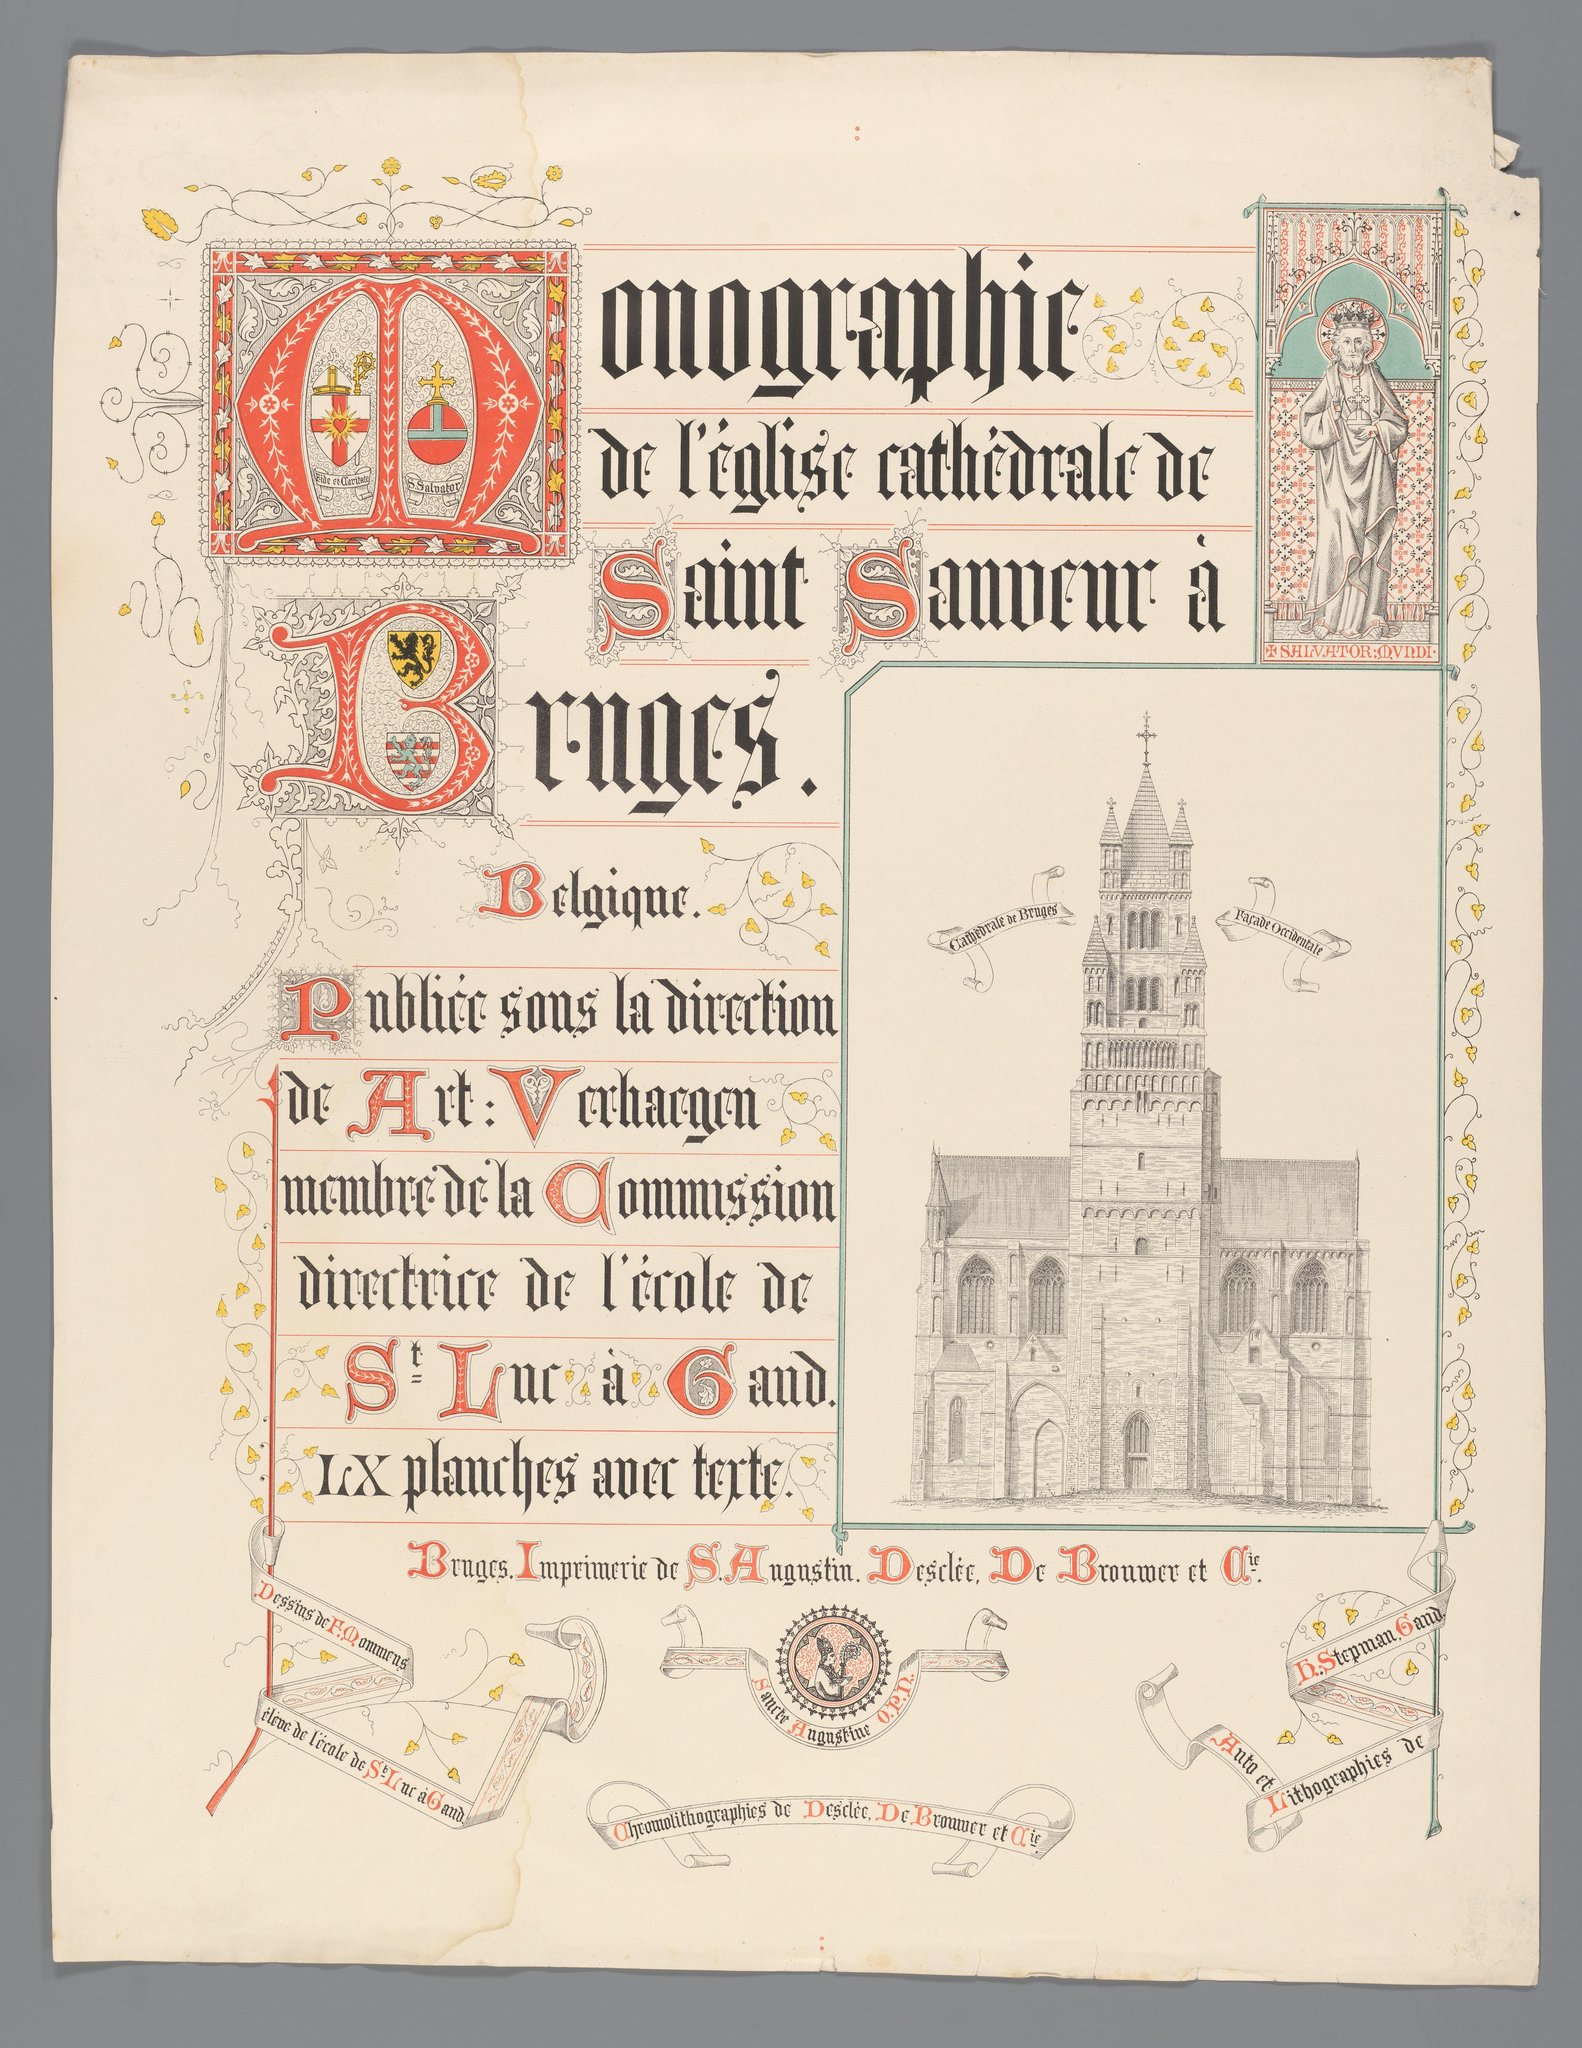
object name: print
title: Sint-Salvatorskathedraal te Brugge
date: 1850-1900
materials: paper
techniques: lithograph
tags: church (exterior), bruges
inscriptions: mark: ‘Dessins de F. Qommius’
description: Blad met gezicht op de Sint-Salvatorskathedraal te Brugge, afbeelding van een beeld van de Heilige Salvator en geornamenteerde tekst.